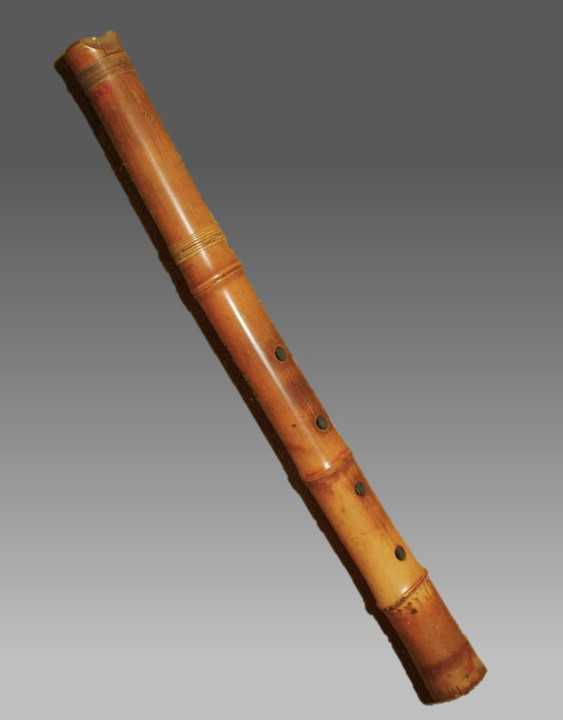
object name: shakuhachi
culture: japanese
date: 1701-1800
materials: bamboo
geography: japan